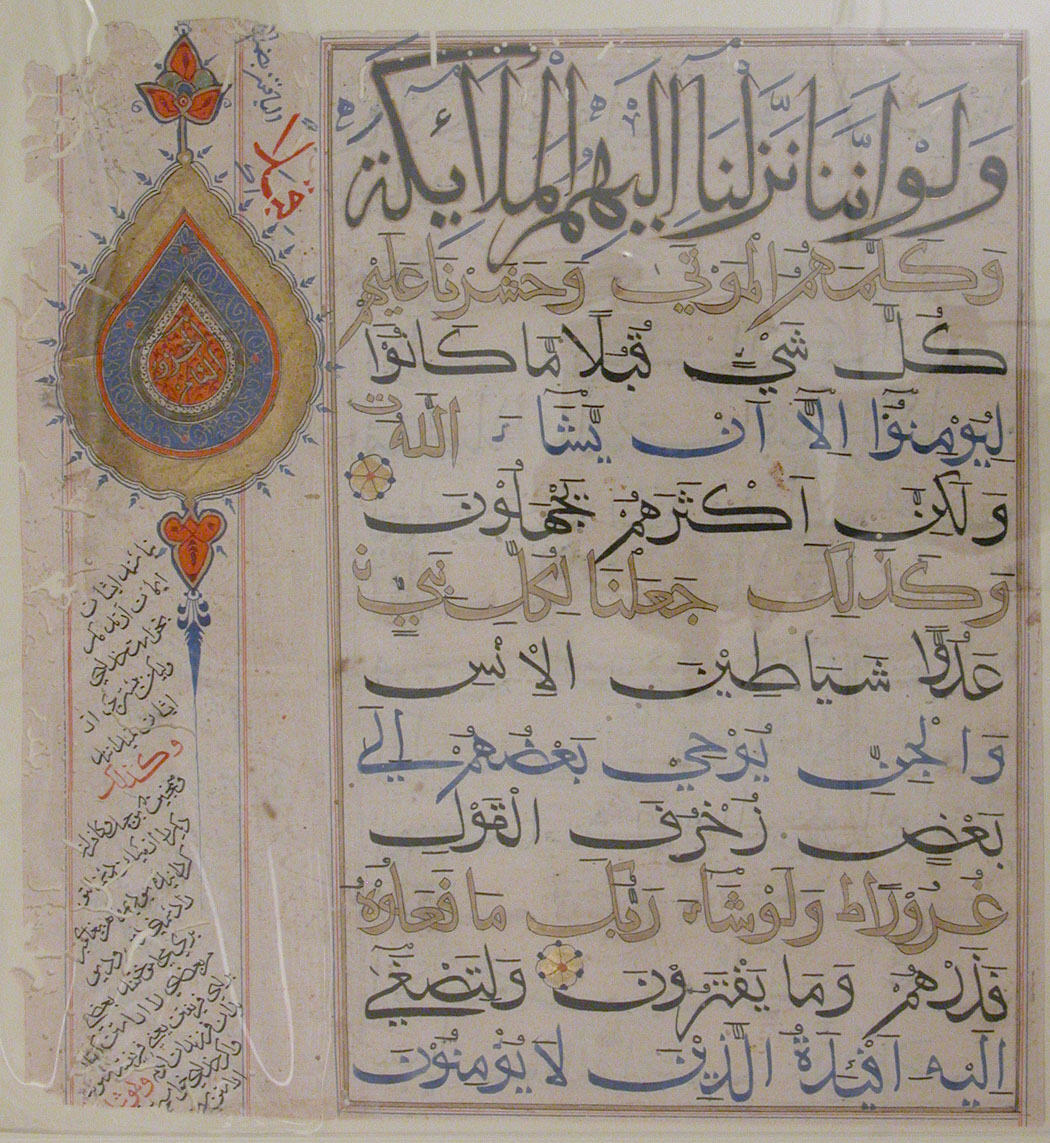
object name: folio from a non illustrated manuscript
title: Folio from a Qur'an Manuscript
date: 1367-1400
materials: gold, ink, paper, watercolor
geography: india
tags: qur'an,calligraphy